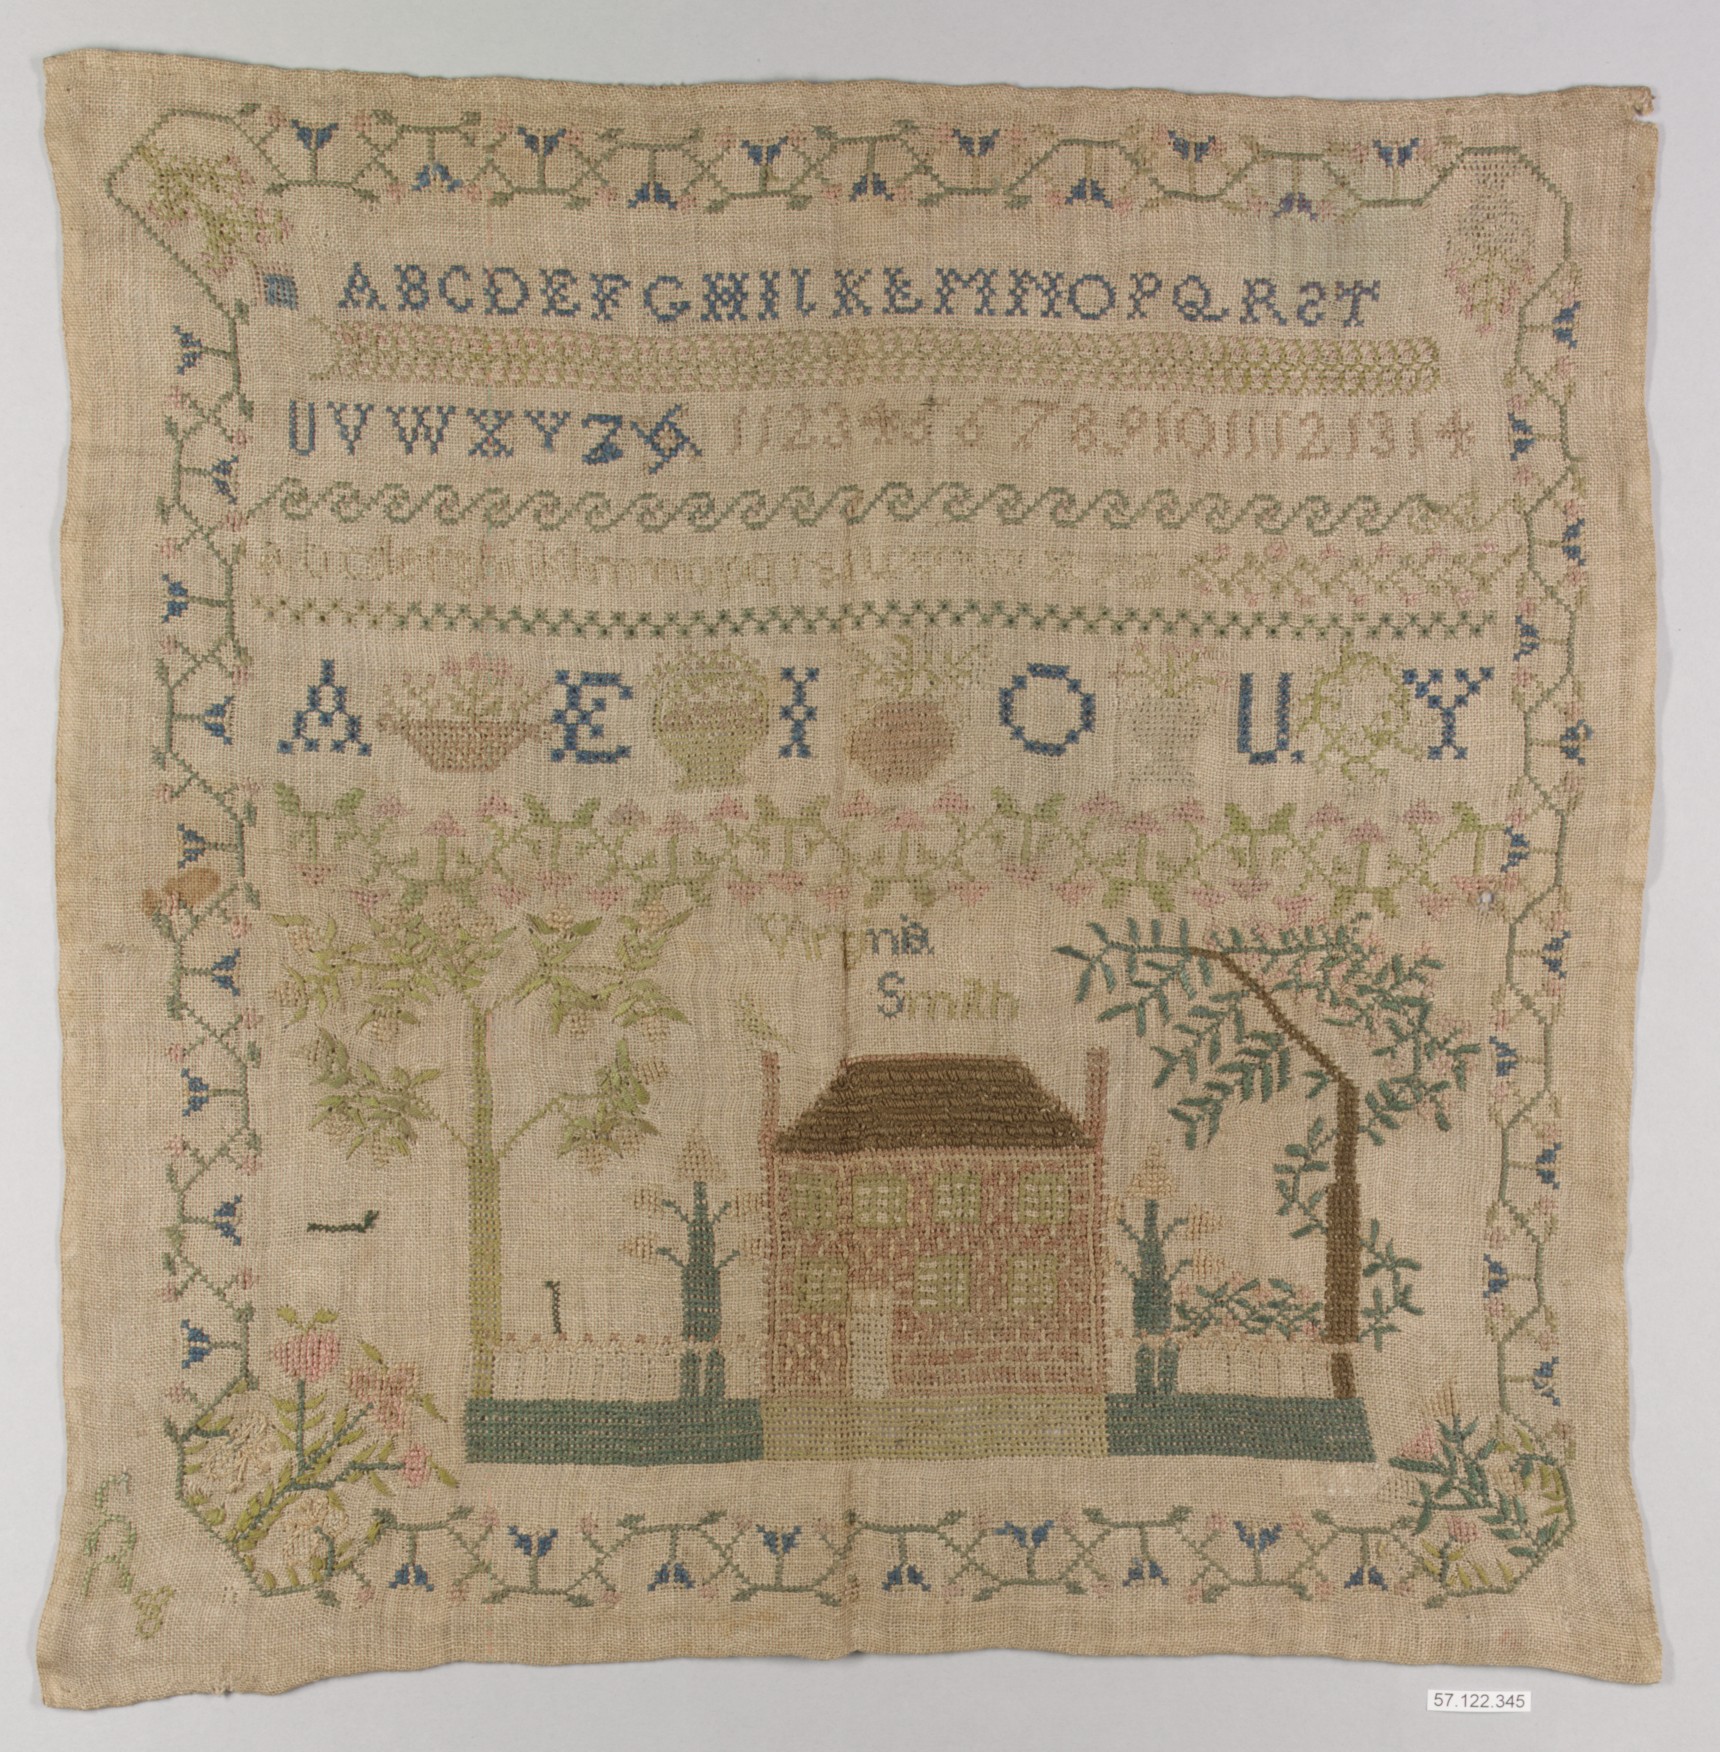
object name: sampler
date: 1801-1900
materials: canvas, linen, silk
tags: houses,trees